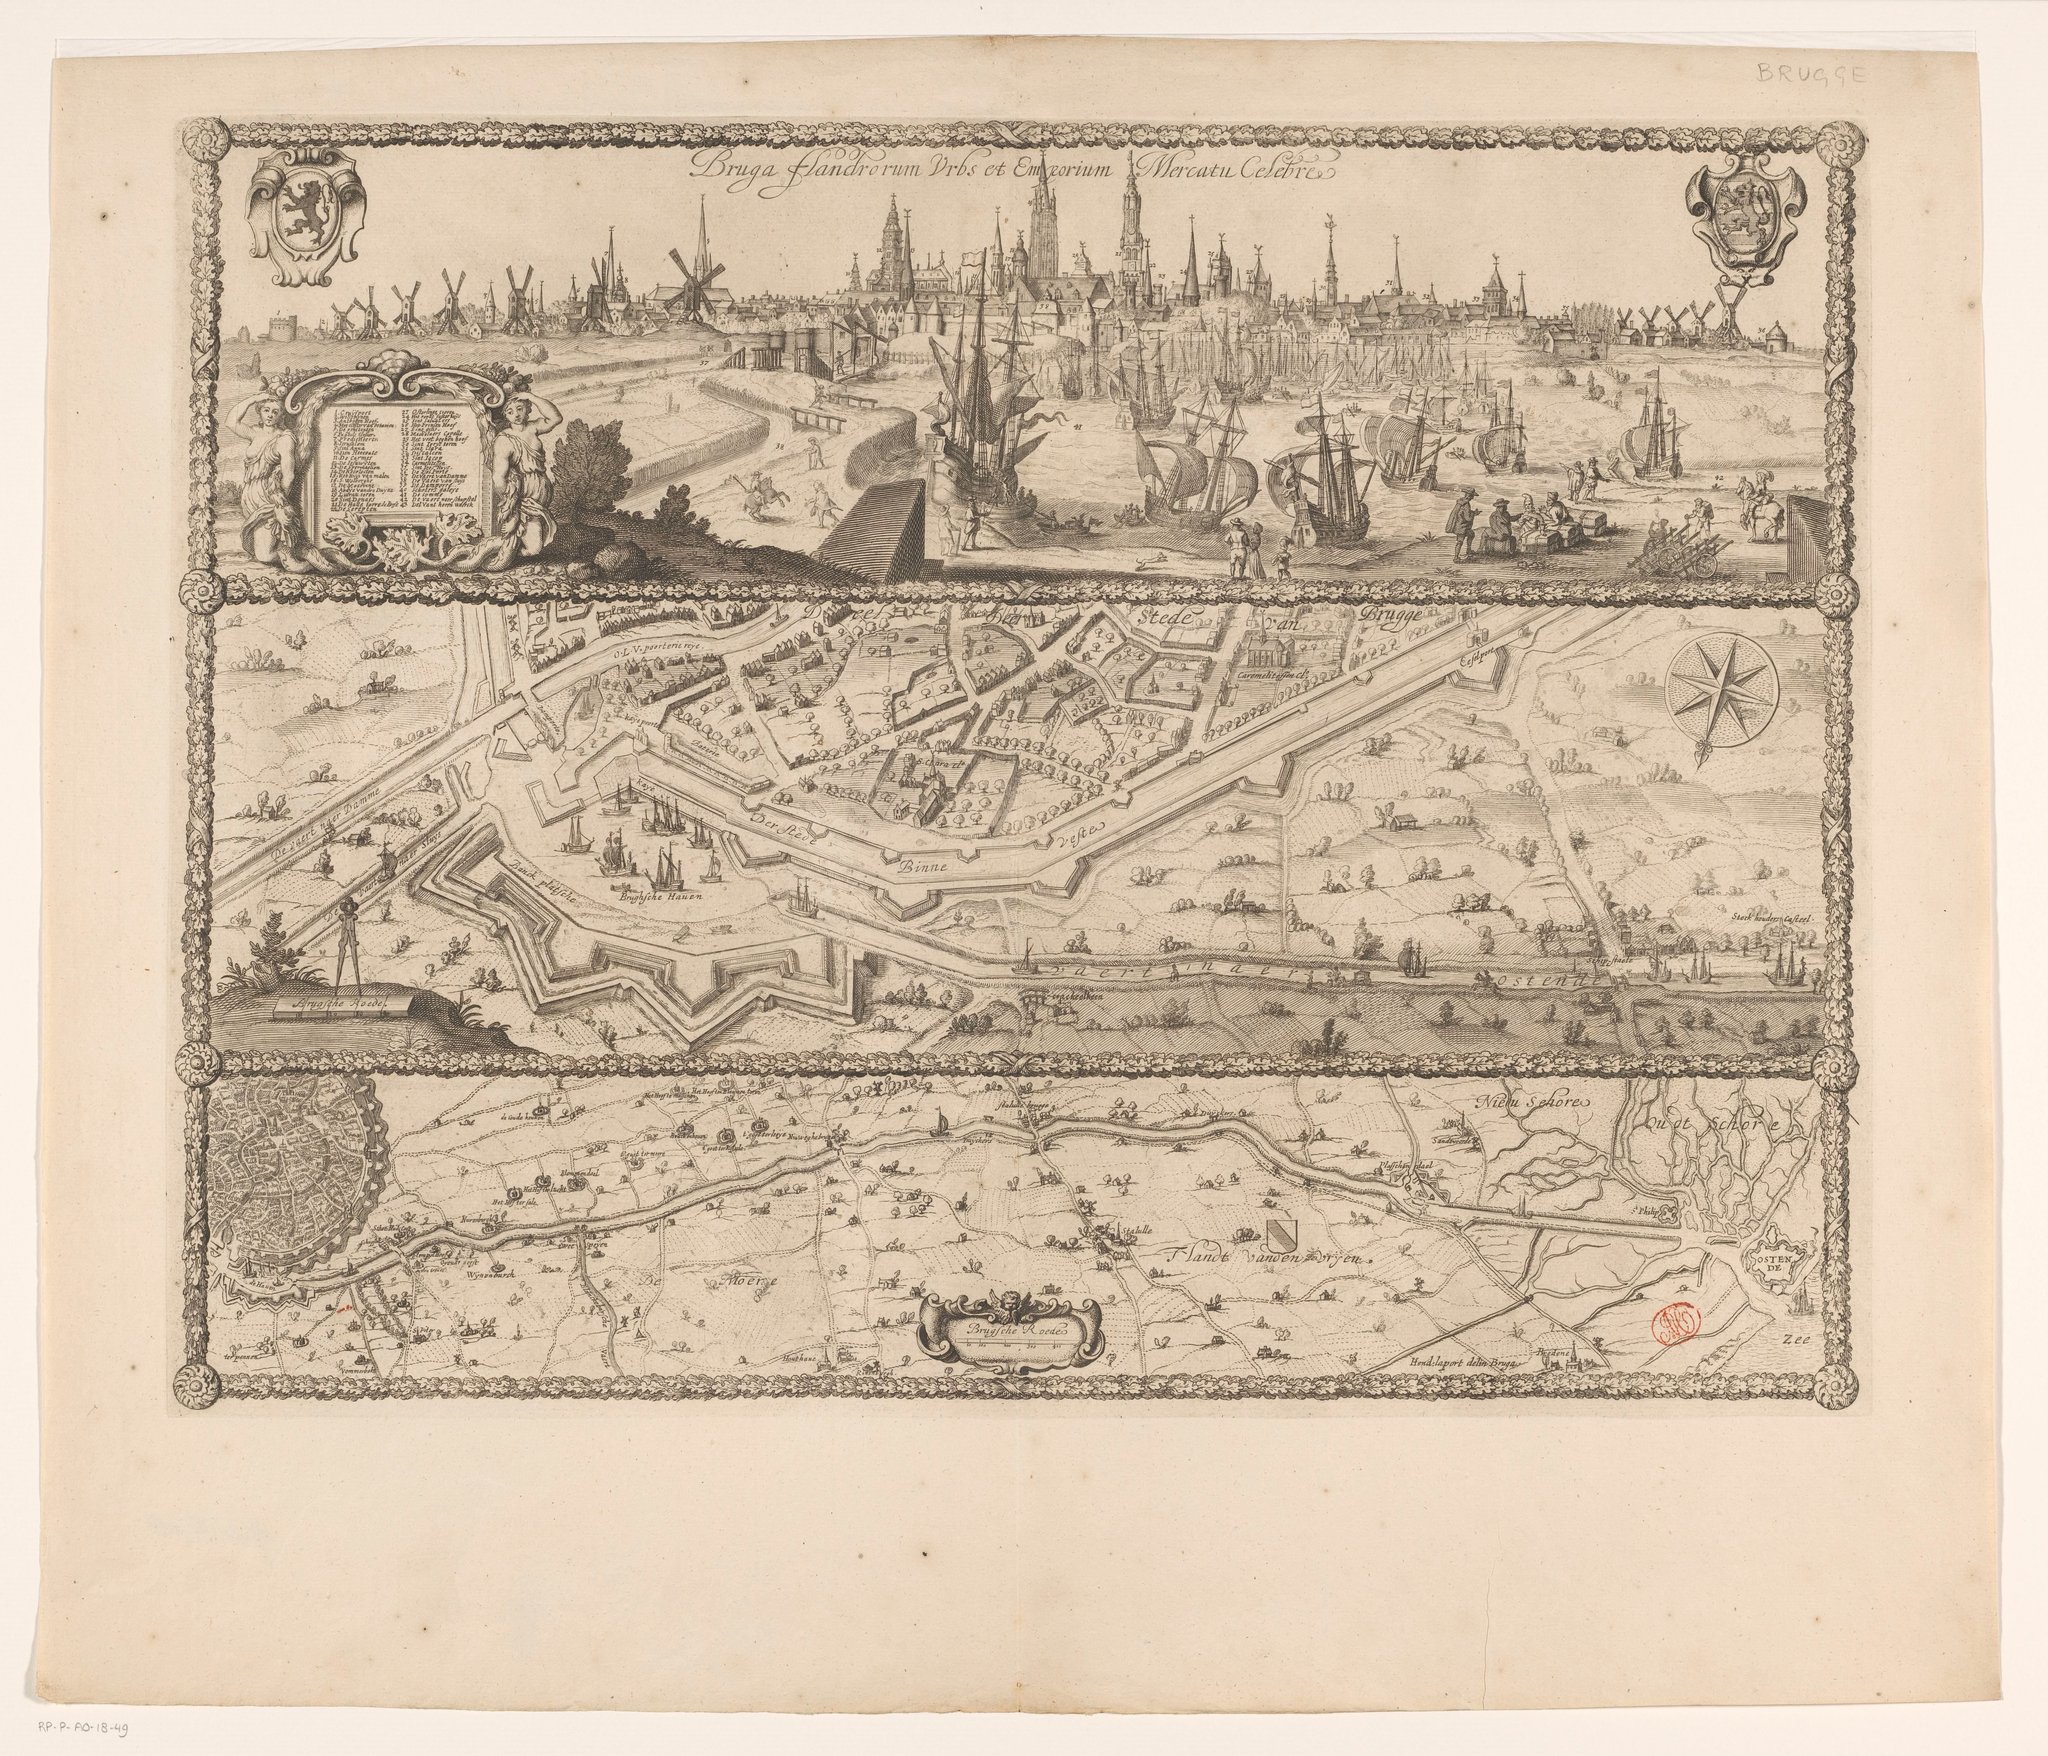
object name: print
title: Drieluik van de haven van Brugge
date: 1665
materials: paper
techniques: engraving, etching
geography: bruges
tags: harbour, coat of arms (as symbol of the state, etc.) (+ city; municipal), sailing-ship, sailing-boat, maps of separate countries or regions, windmill, maps of cities, coat of arms (as symbol of the state, etc.) (+ province; provincial), prospect of city, town panorama, silhouette of city, bruges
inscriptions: collector's mark: Lugt 195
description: Drieluik van de haven van Brugge. In het bovenste deel van de prent een gezicht op de haven van Brugge, met op de voorgrond figuren, in het water schepen en molens rond de stad. Linksboven het wapen van het graafschap Vlaanderen. Rechtsboven het wapen van Brugge. Linksonder een cartouche met legenda 1-43. In het middelste deel een gezicht in vogelvluchtperspectief op de haven van Brugge en het begin van het kanaal naar Oostende. Linksonder een schaalstok: 40 Brugsche Roede. In het onderste deel een kaart van het kanaal van Brugge naar Oostende. Onder, in het midden, een cartouche met schaalstok: 500 Brugsche Roede. Rechtsboven de cartouche het wapen van het Brugse Vrije. De prent zou gemaakt zijn om de goede bereikbaarheid van de stad, verbeterd door de aanleg van een nieuwe havenkom, te verkondigen.